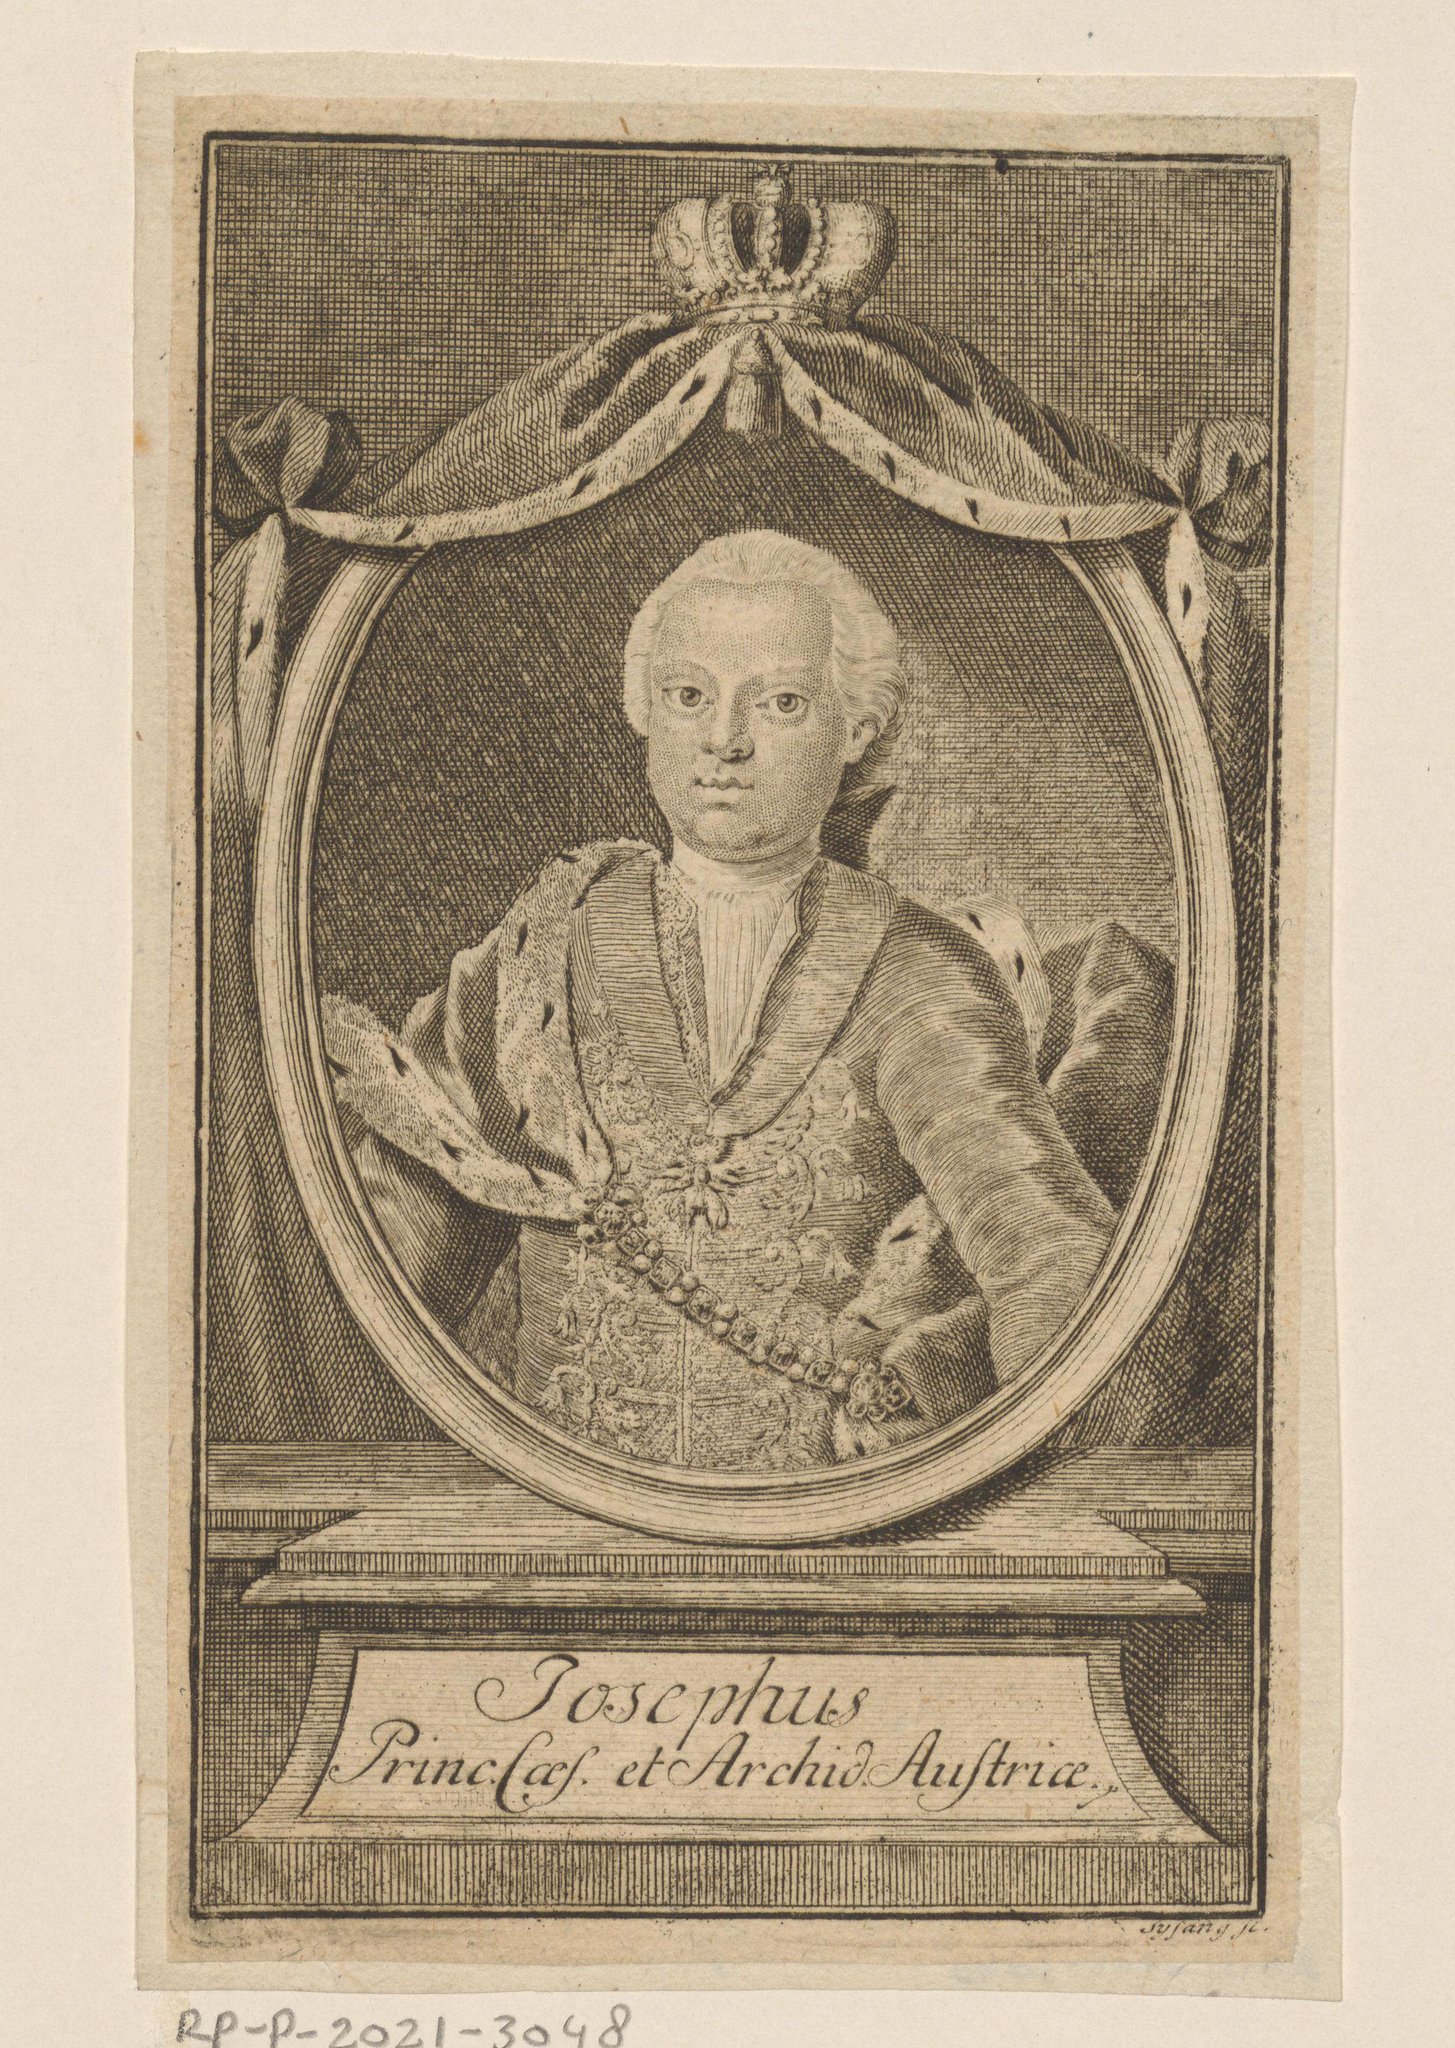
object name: print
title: Portret van Jozef II, Duits keizer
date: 1751-1765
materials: paper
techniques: engraving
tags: jozef ii (duits keizer), crown (symbol of sovereignty), historical persons, emperor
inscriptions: inscription: ‘No. 547’